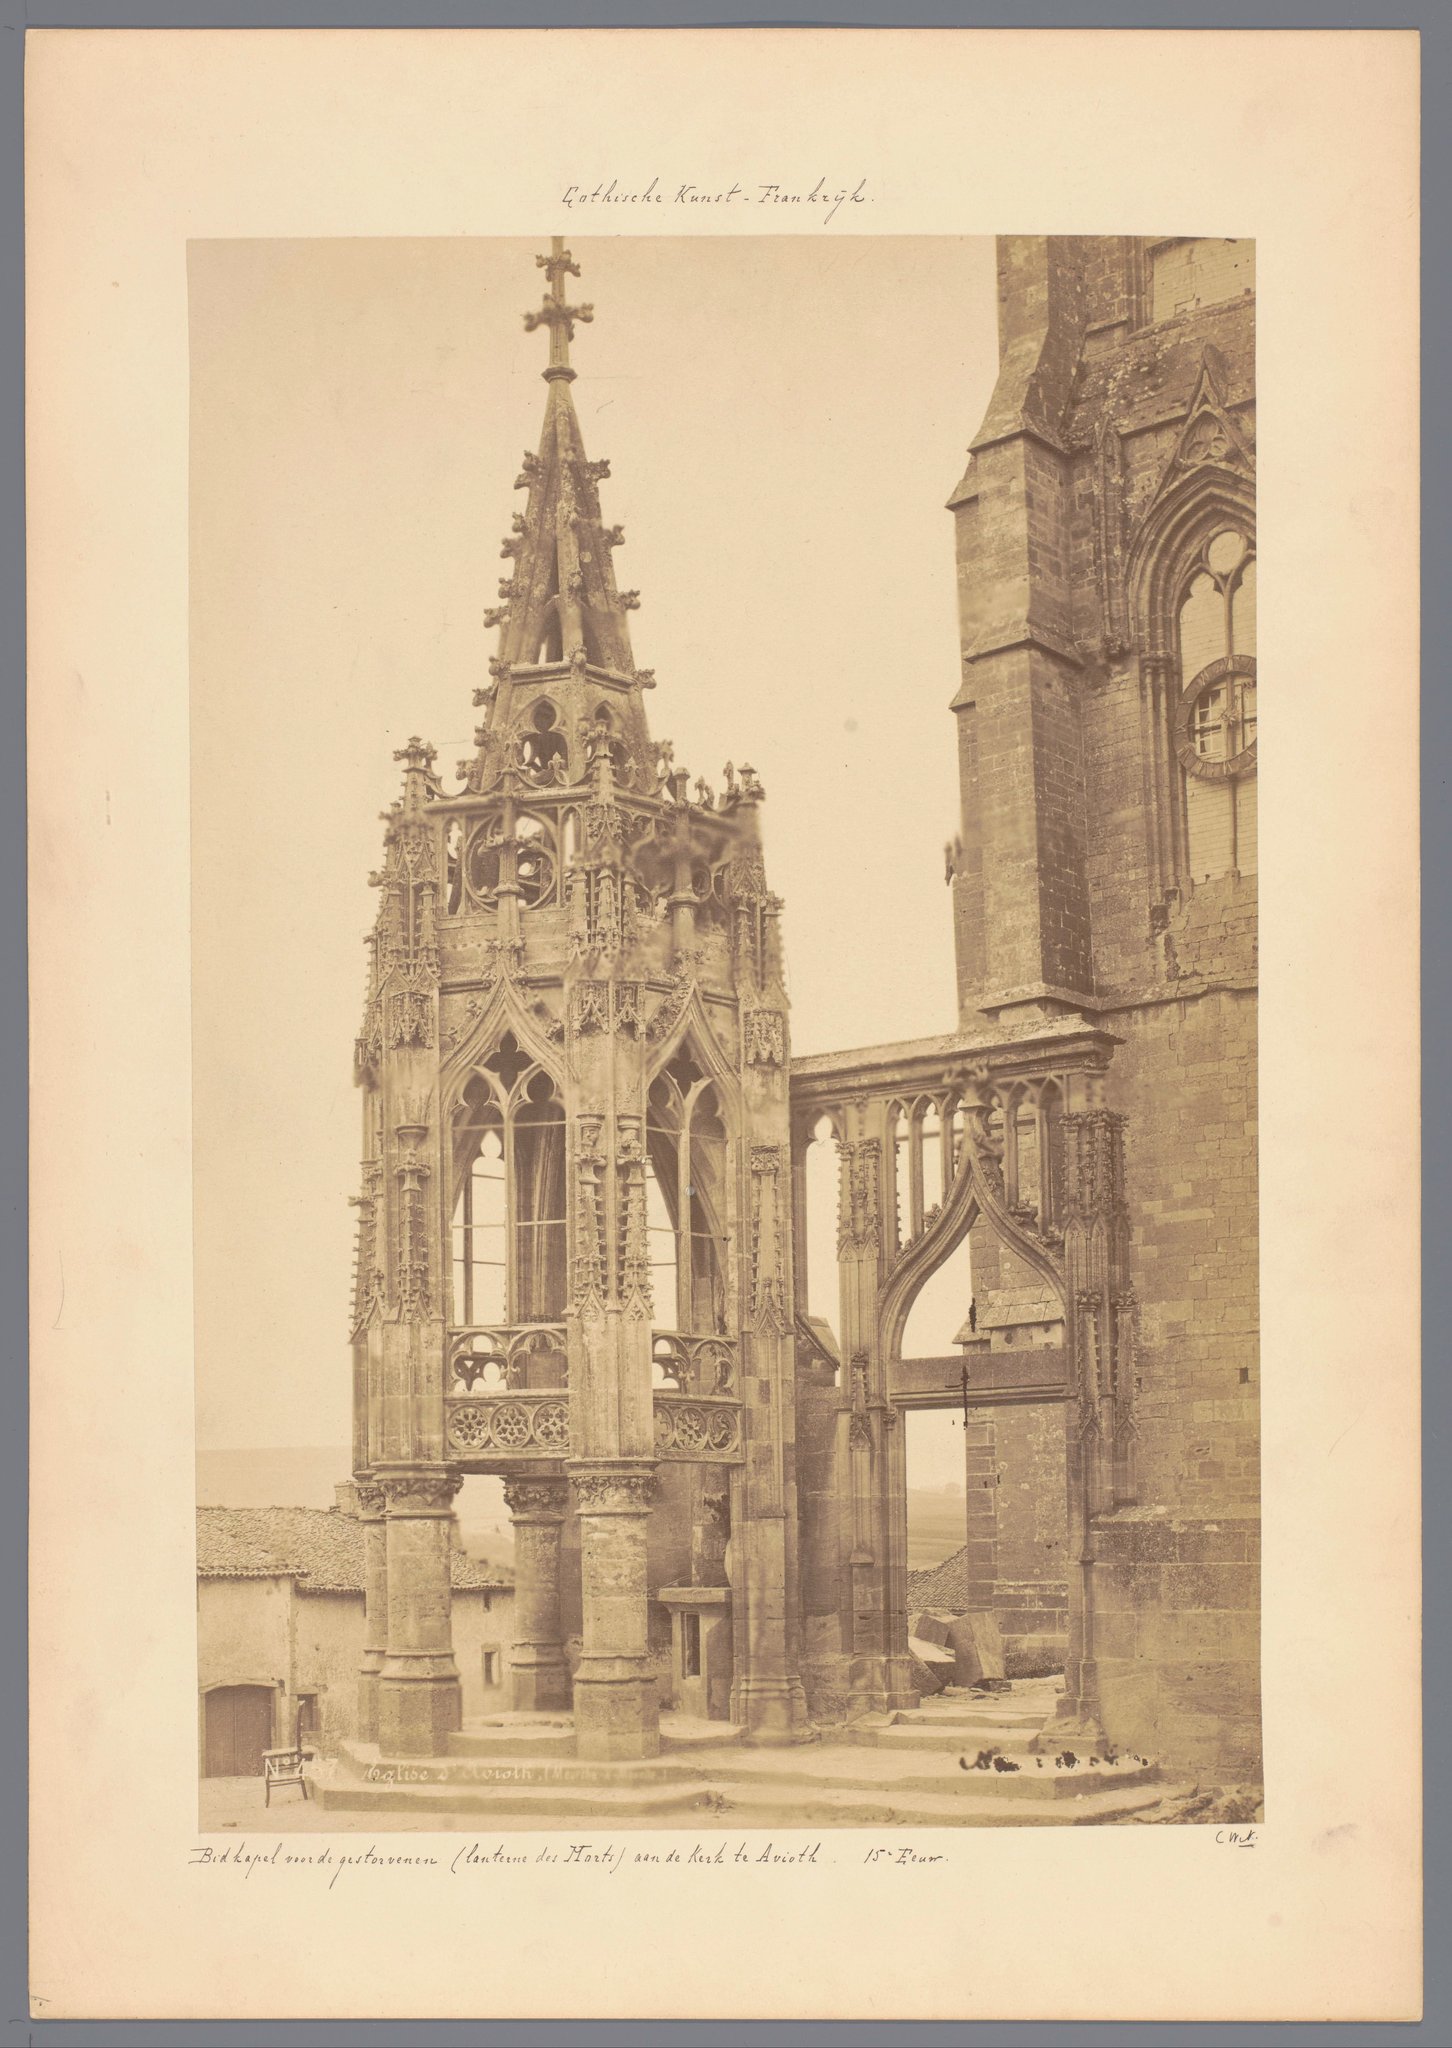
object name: photograph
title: Exterieur van de bidkapel La Recevresse bij de Basilique Notre-Dame te Avioth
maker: paul robert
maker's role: fotograaf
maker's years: 1865-1905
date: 1875-1900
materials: cardboard, photographic support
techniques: albumen print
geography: avioth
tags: tower, clock tower ~ monumental adornment, church (exterior) - qq - small church, chapel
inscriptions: number: ‘No. 457’, collector's mark: ‘INSTITUUT VOOR KUNST-NIJVERHEIDSONDERWIJS GABRIËL METSUSTRAAT No. 16 AMSTERDAM’, name: ‘PAUL ROBERT PARIS’, inscription: ‘CWN.’, inscription: ‘MONUMENTS HISTORIQUES’, collector's mark: ‘KUNSTNIJVERHEIDSCHOOL QUELLINUS AMSTERDAM FRANS HALSSTRAAT 14.’, inscription: ‘Gothische Kunst - Frankrijk.’